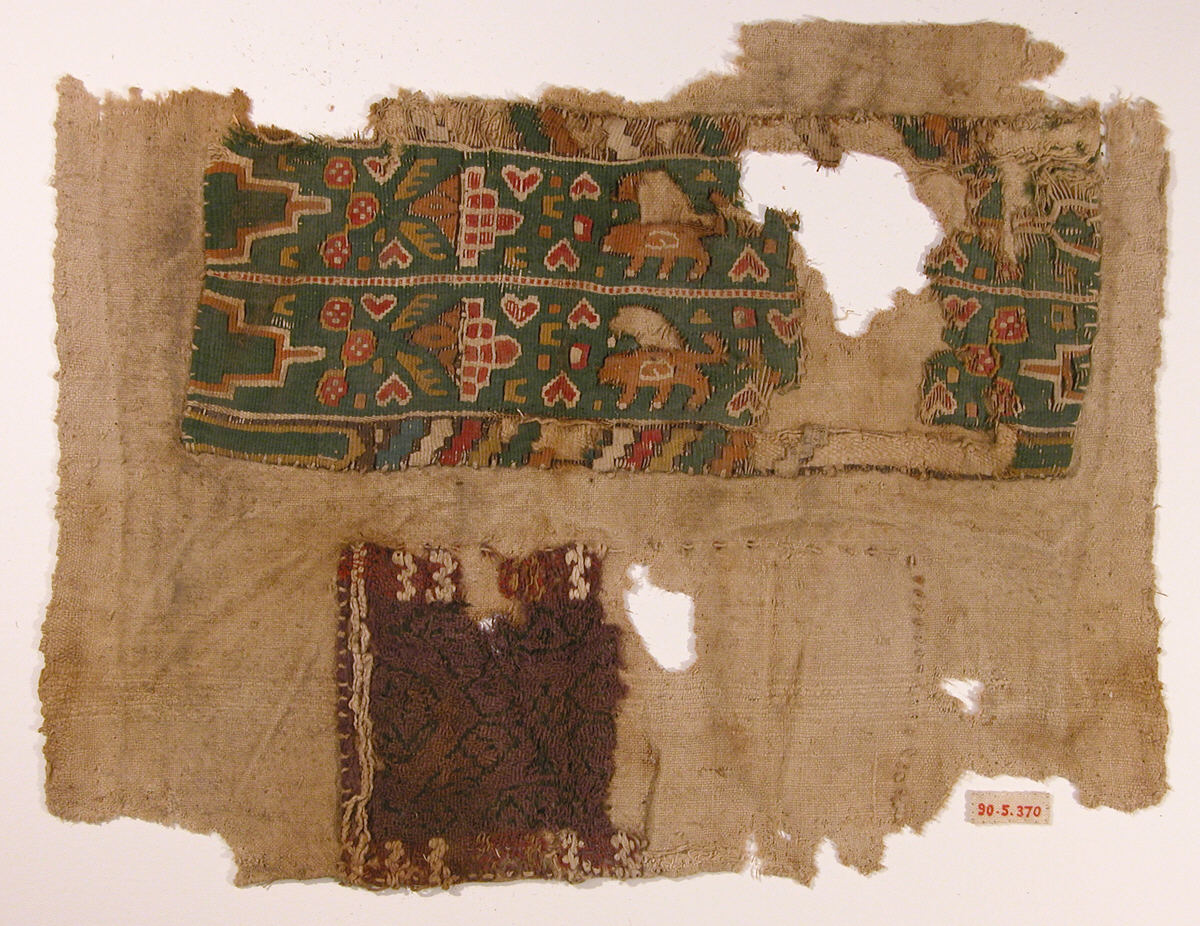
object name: textile fragment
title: Fragment of a Sleeve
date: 501-600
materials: linen, wool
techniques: weave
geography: egypt